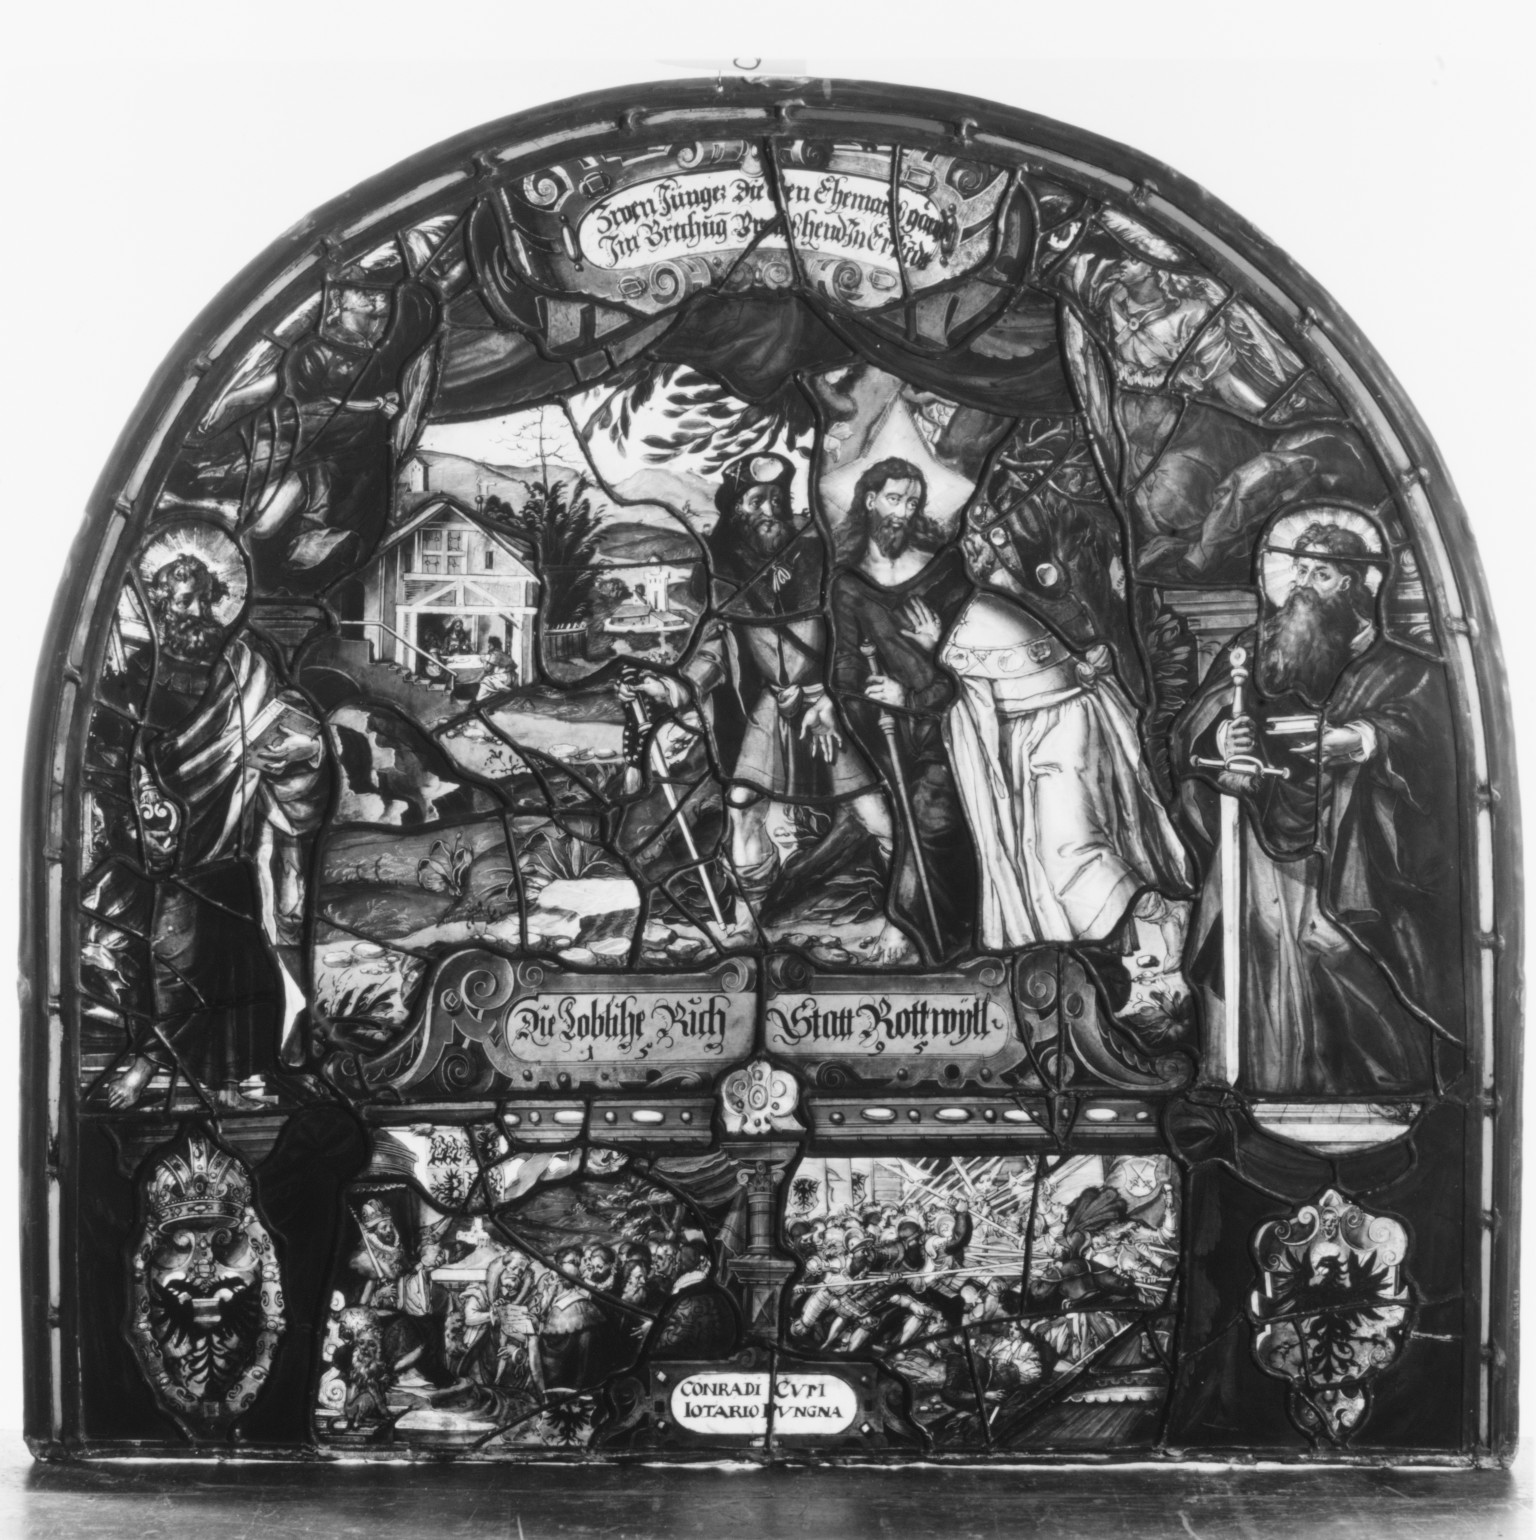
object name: panel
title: The Encounter on the Way to Emmaus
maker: franz fallenter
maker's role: artist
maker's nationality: german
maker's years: 1550-1616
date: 1595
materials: glass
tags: battles,men,christ